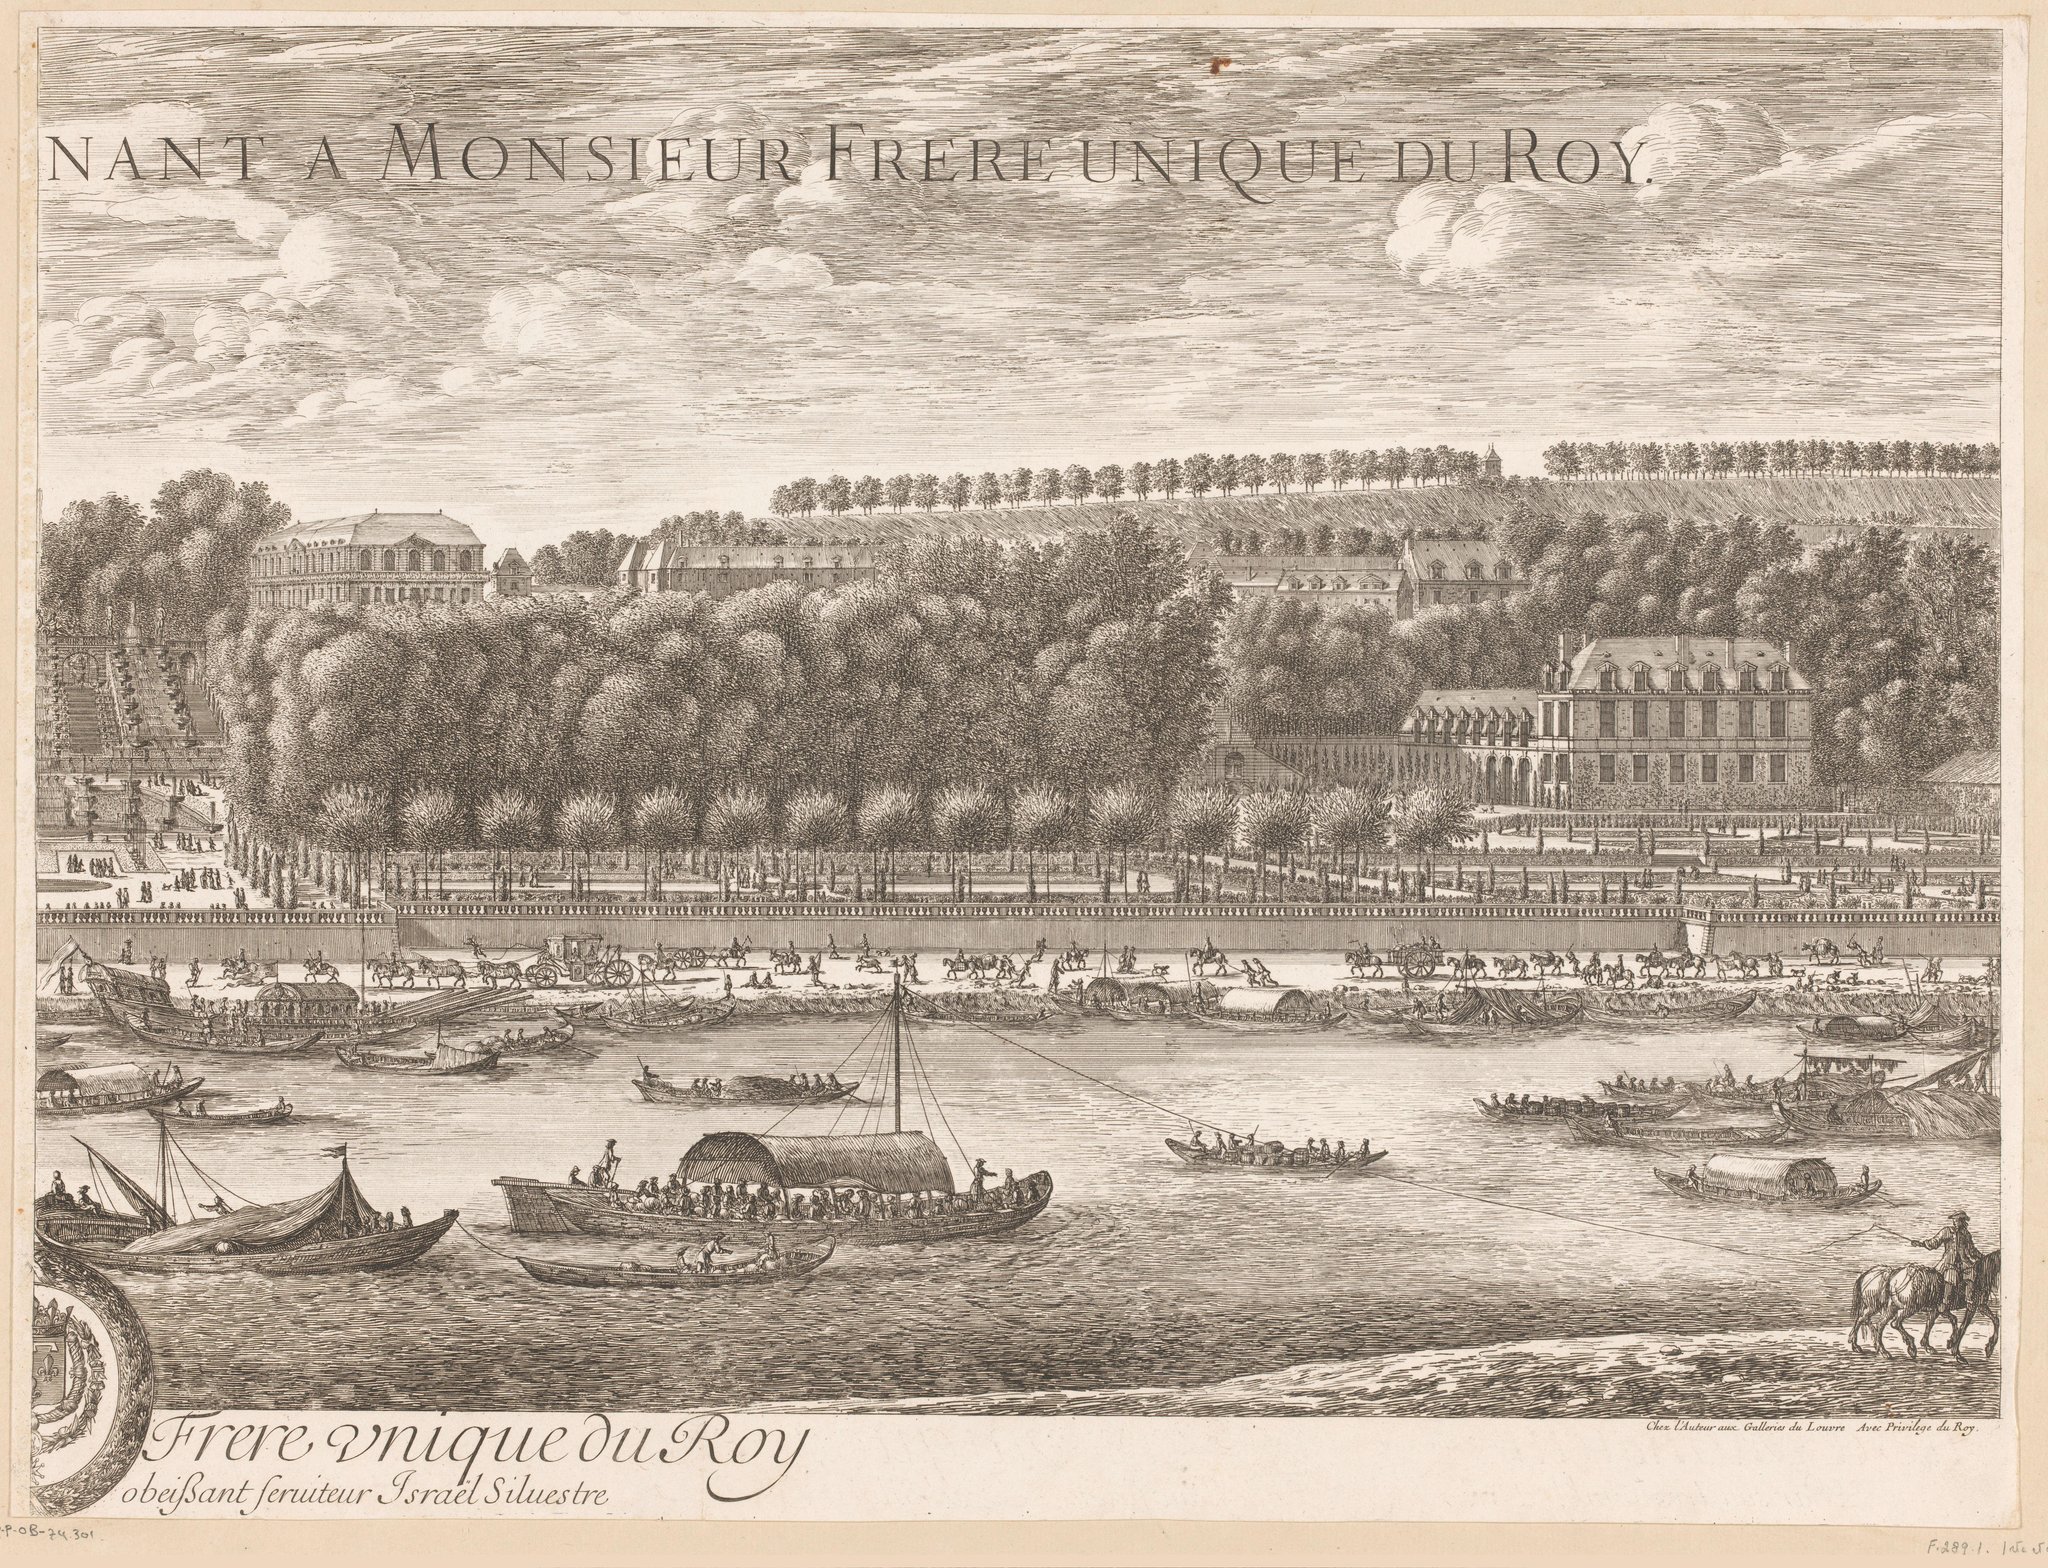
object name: print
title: Gezicht op kasteel Saint-Cloud (rechter deel)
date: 1671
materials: paper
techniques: engraving, etching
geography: france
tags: city-view, and landscape with man-made constructions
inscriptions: collector's mark: Lugt 240